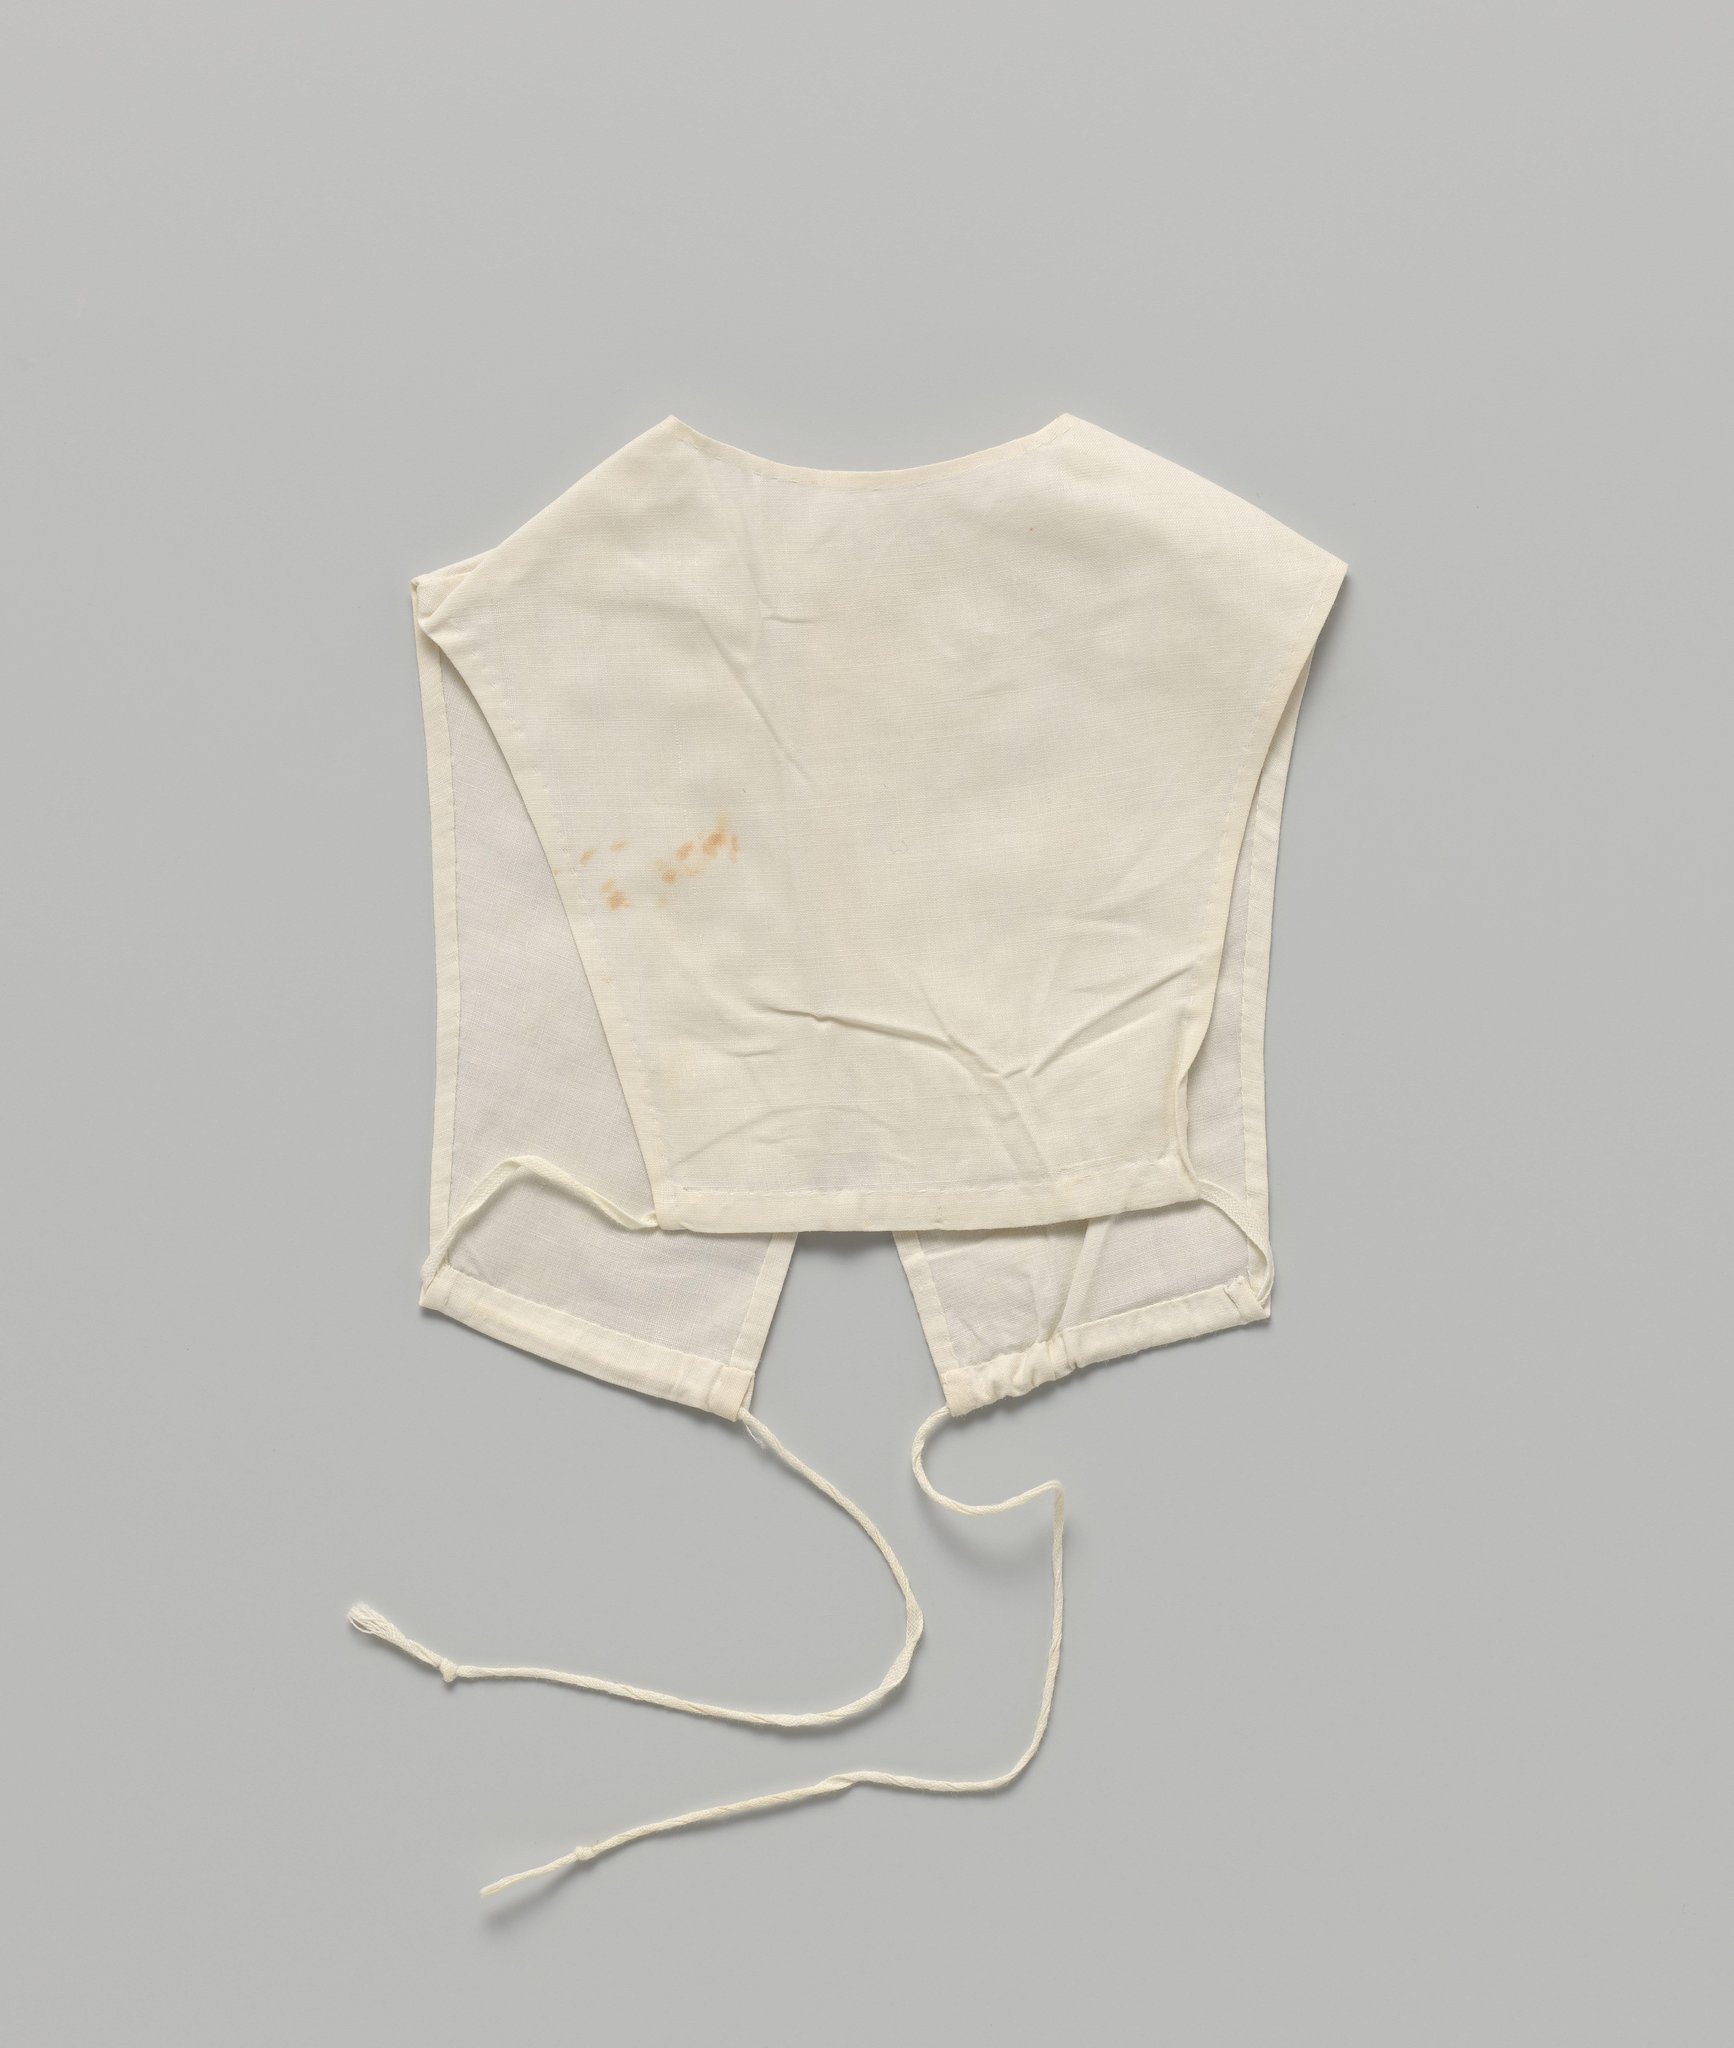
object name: corsage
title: Lijfje van effen wit textiel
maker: Anonymous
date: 1850-1920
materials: textile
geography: netherlands